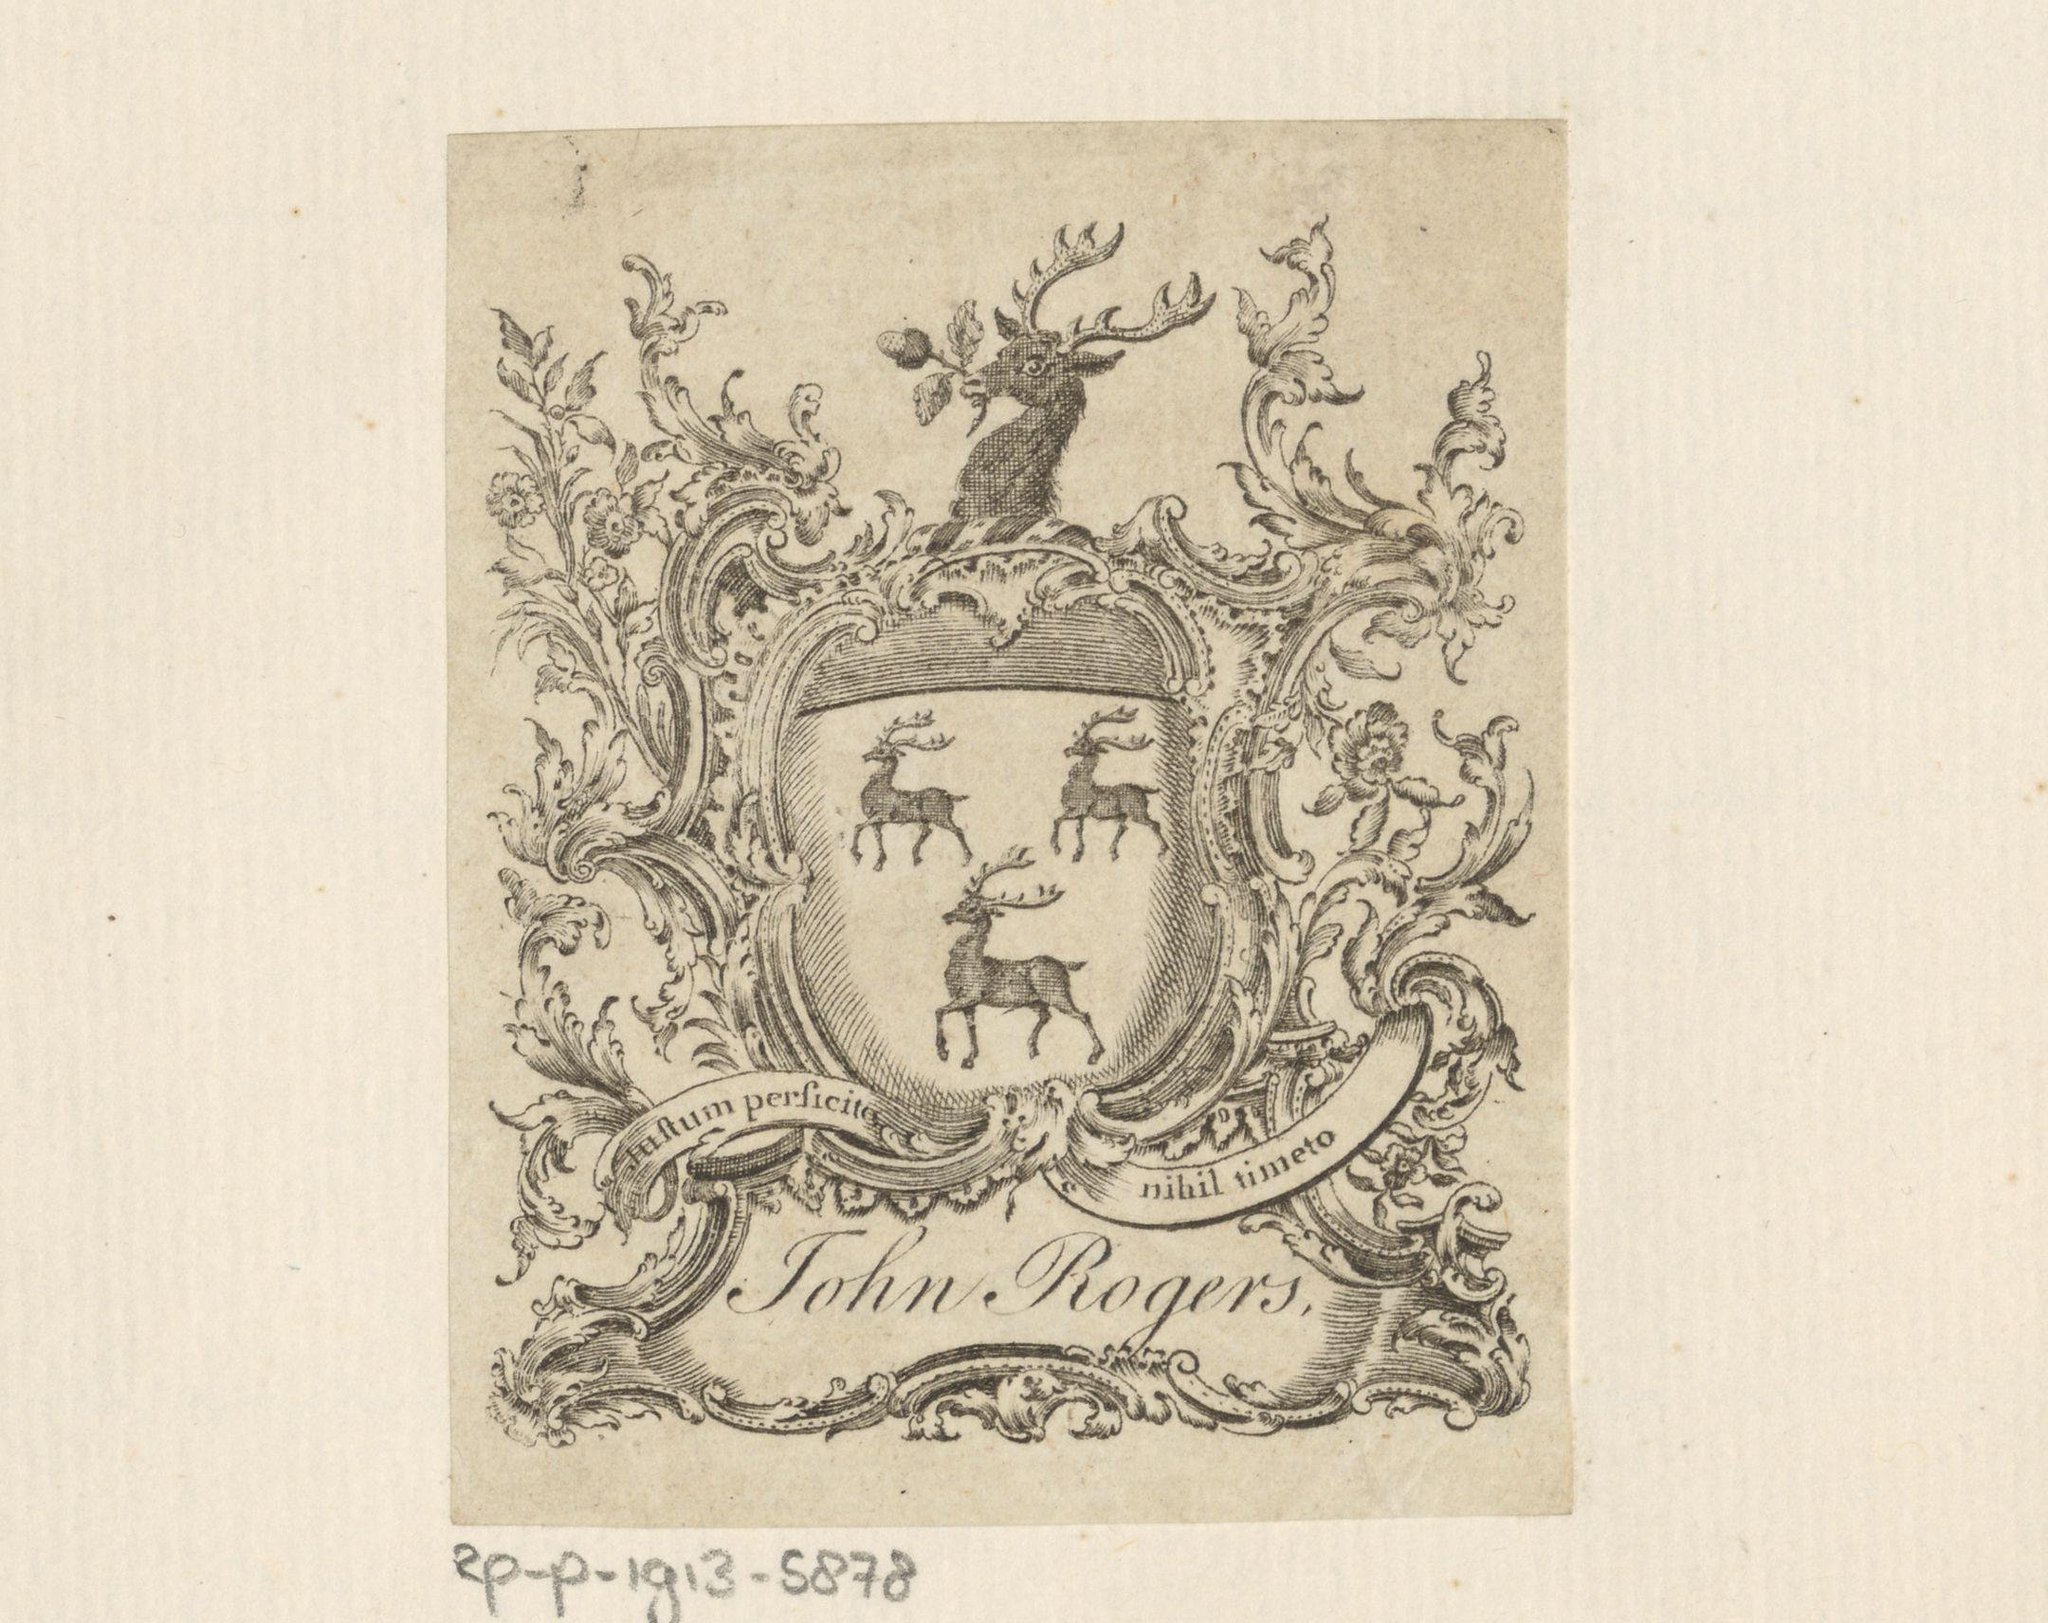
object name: bookplate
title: Justum perficto nihil timeto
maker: Anonymous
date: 1750-1799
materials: paper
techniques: engraving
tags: armorial bearing, heraldry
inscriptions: collector's mark: Lugt 2233, collector's mark: Lugt 2760